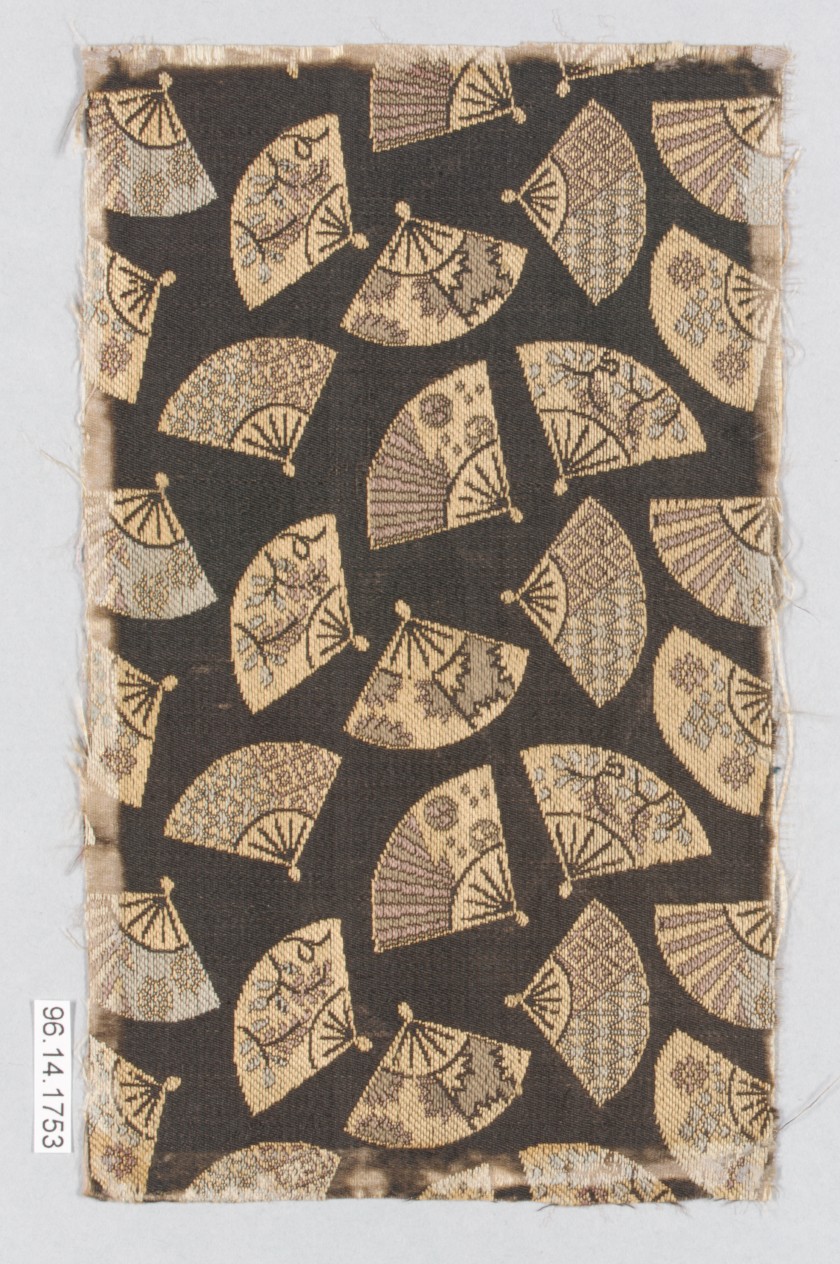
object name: piece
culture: japanese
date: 1801-1900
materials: silk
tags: fans